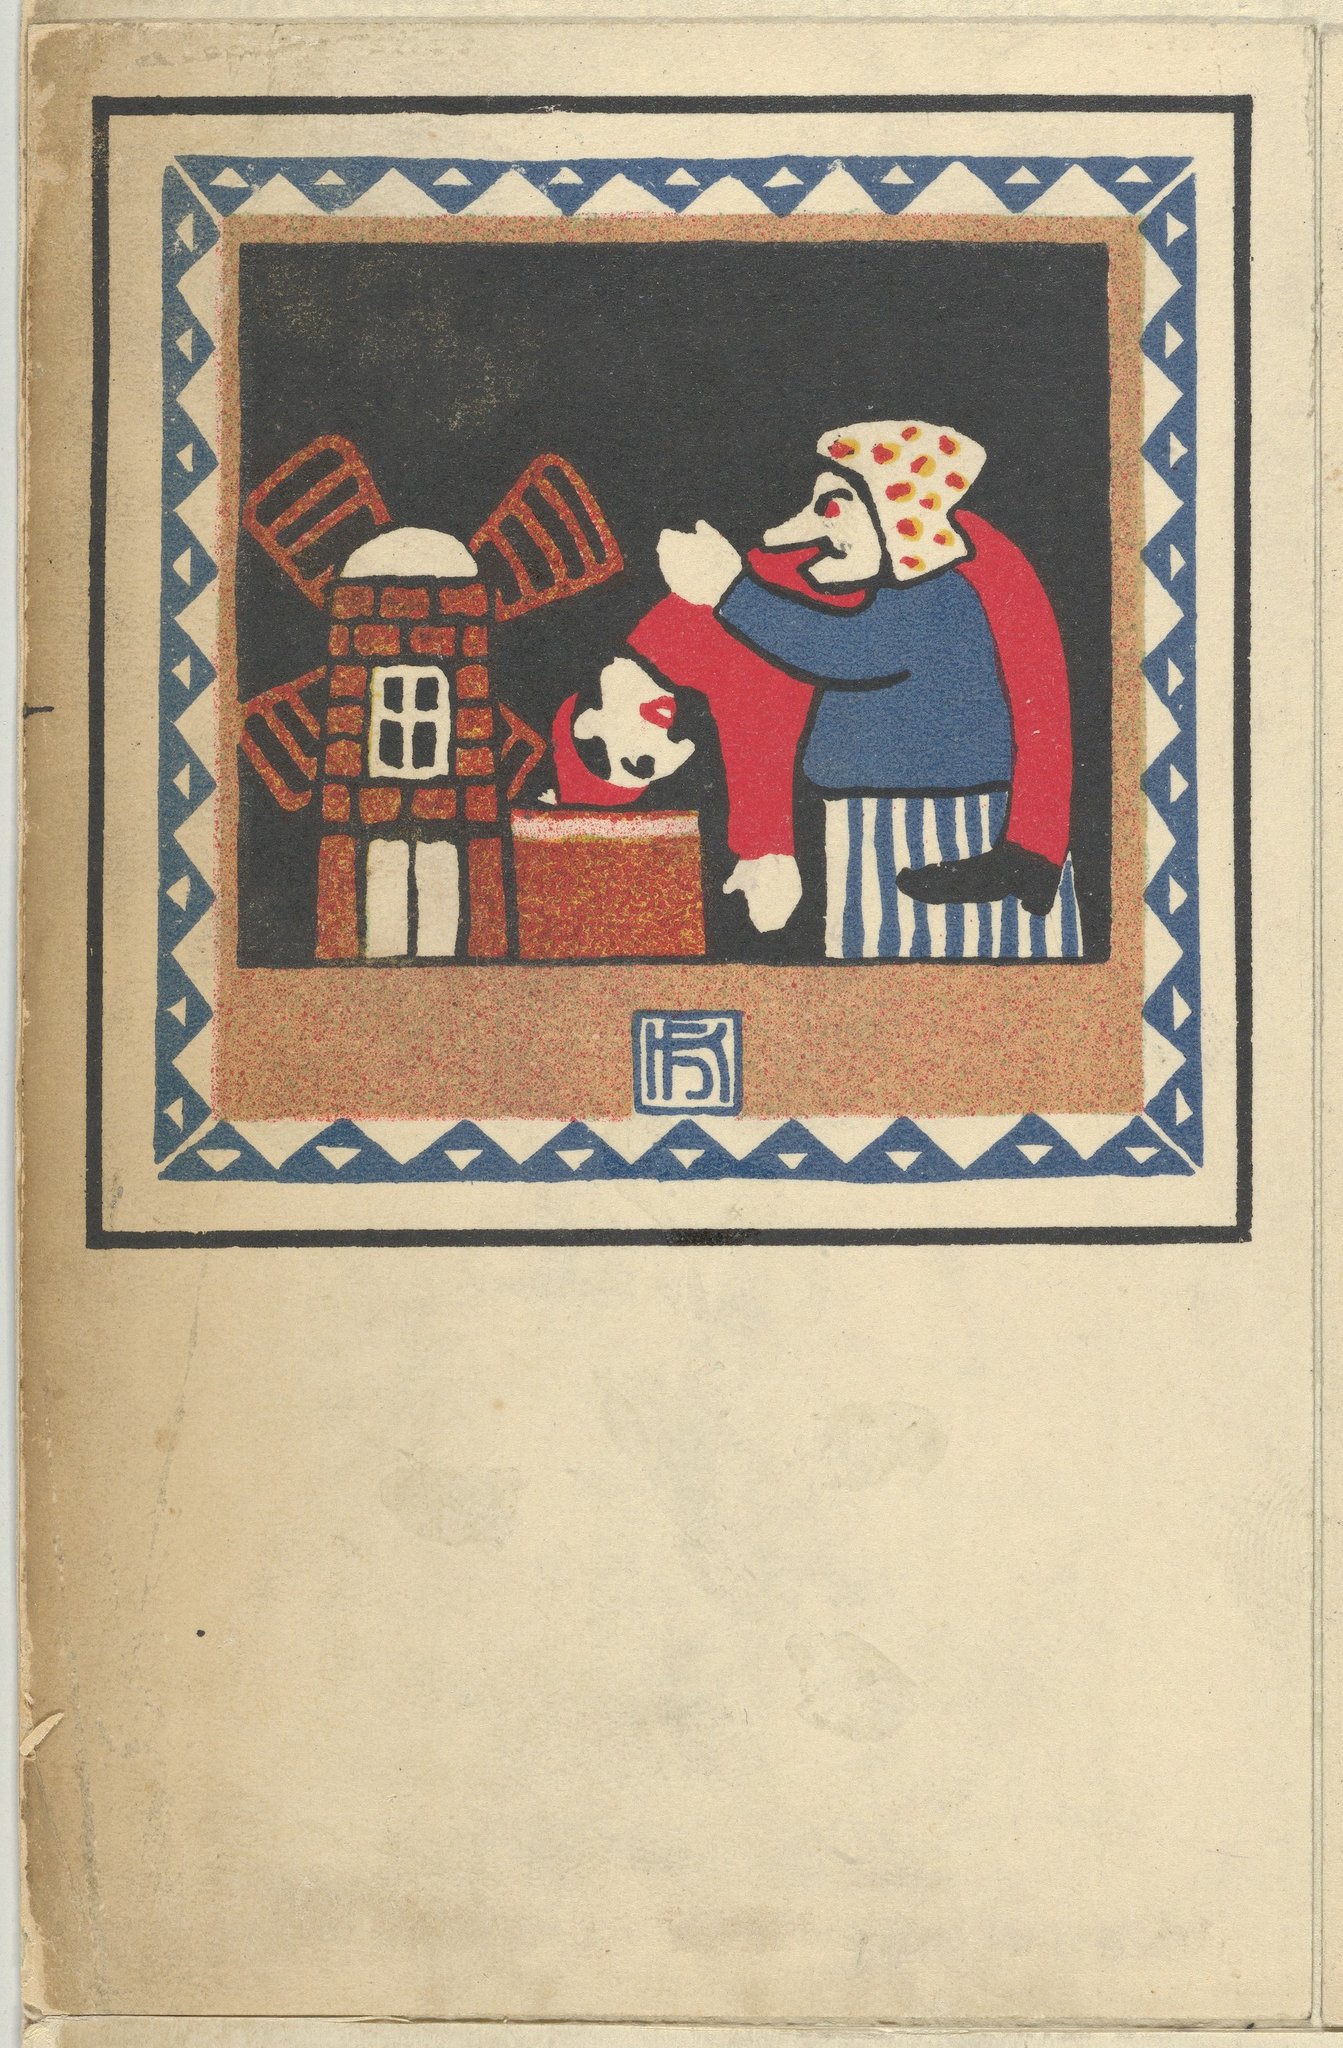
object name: print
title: Kasperltheater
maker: hans kalmsteiner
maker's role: artist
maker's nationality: austrian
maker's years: 1882-1914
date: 1907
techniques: lithograph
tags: human figures,windmills